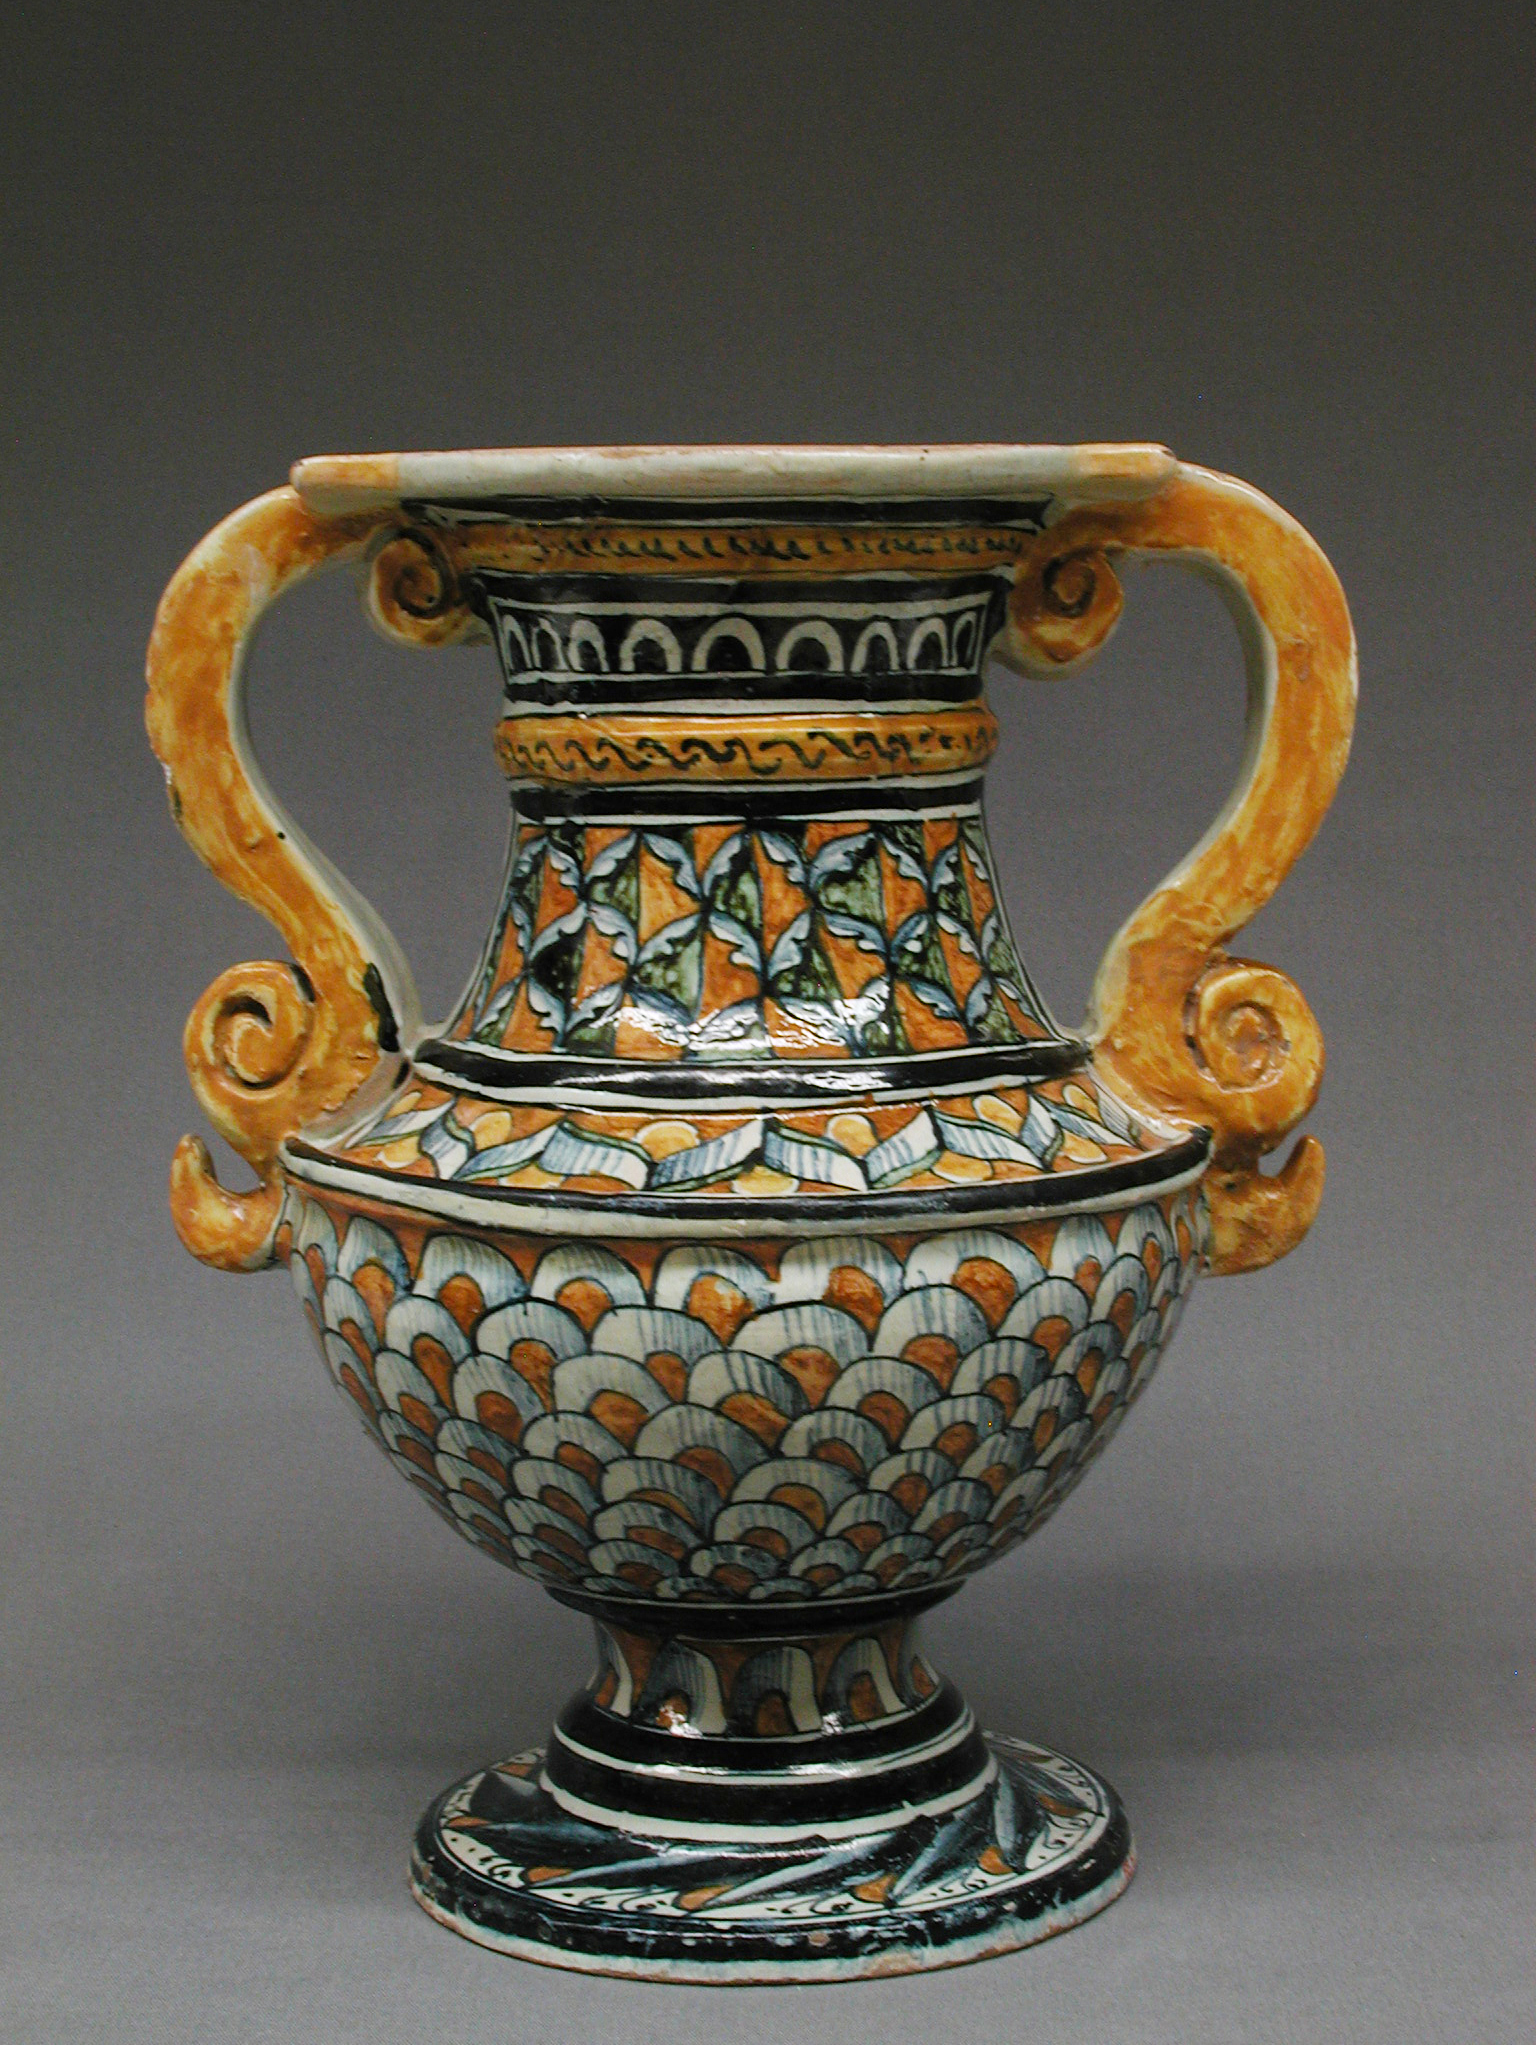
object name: vase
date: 1467-1500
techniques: maiolica, glazing